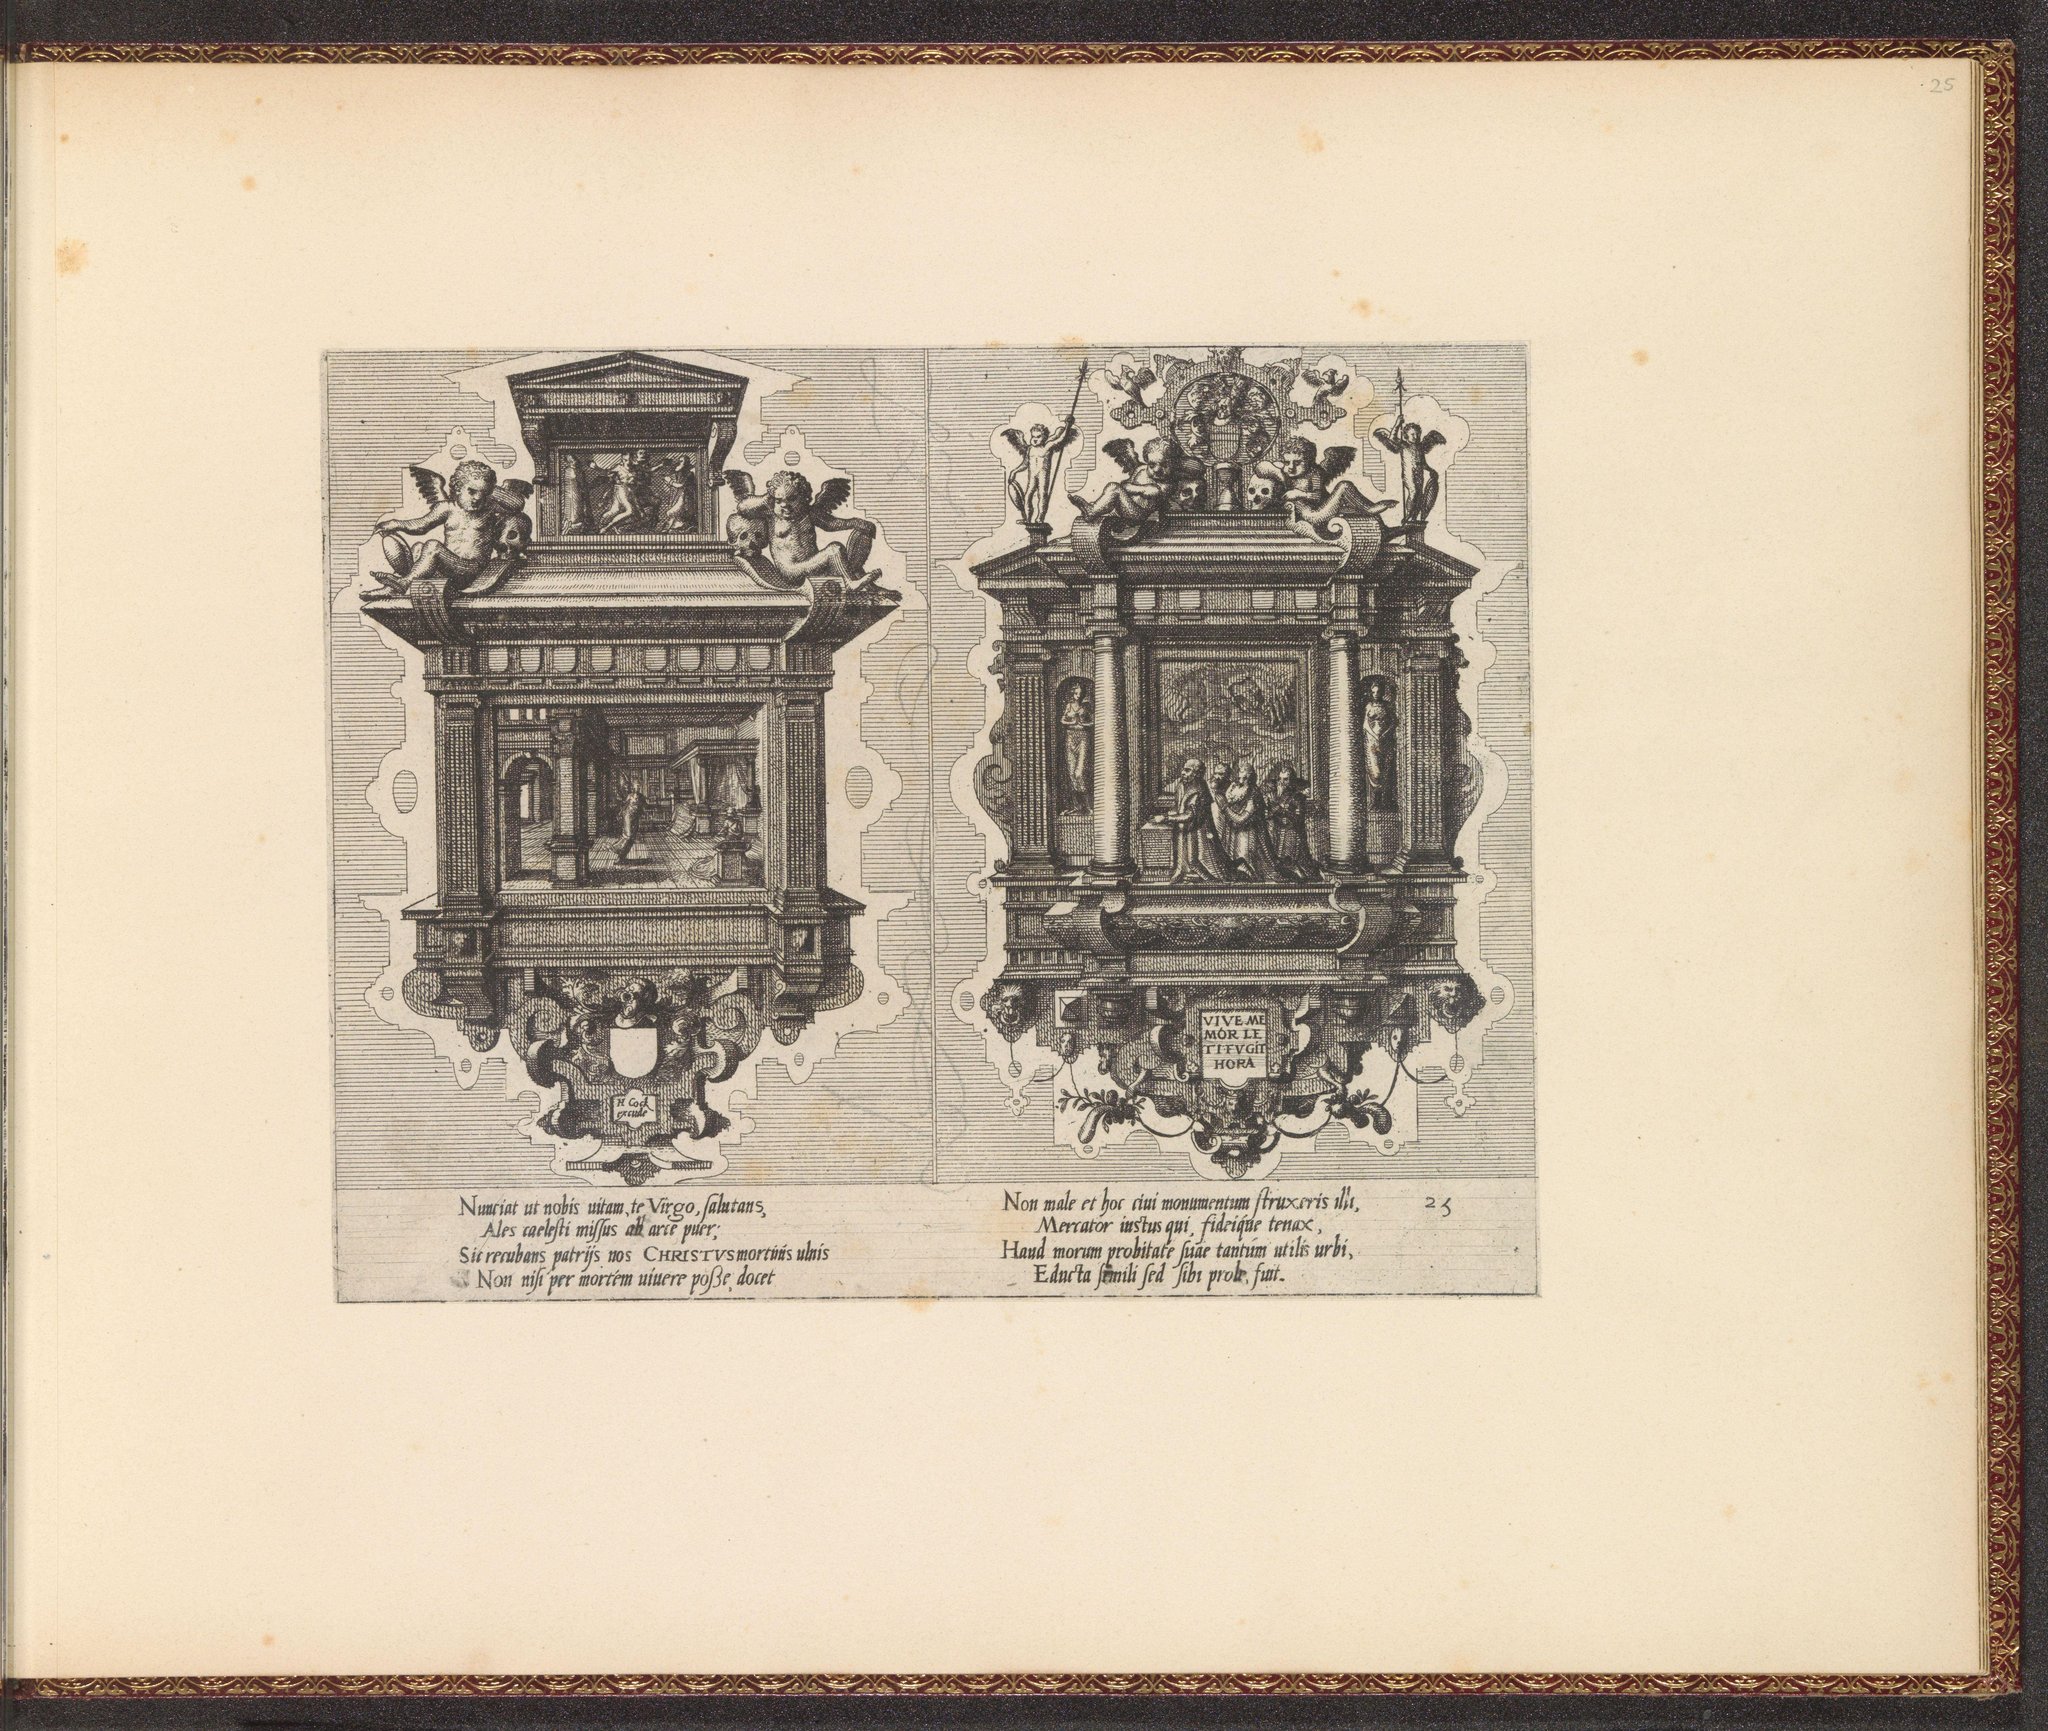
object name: print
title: Twee epitafen, de llinker met Annunciatie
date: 1563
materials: paper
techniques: etching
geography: antwerp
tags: grave-building, monumental tomb, grave, tomb and other grave-forms and grave-markers, epitaph, the announcement of christ's birth (luke 1:26-38)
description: Twee epitafen of grafmonumenten die tegen een wand geplaatst moeten worden. De epitaaf links een architecturale omlijsting met de Annunciatie. Rechts vier knielende, biddende mannen geflankeerd door twee Ionische zuilen en twee nissen met vrouwenbeelden. In de ondermarge acht regels tekst, in twee kolommen, in het Latijn. De prent maakt deel uit van een album.